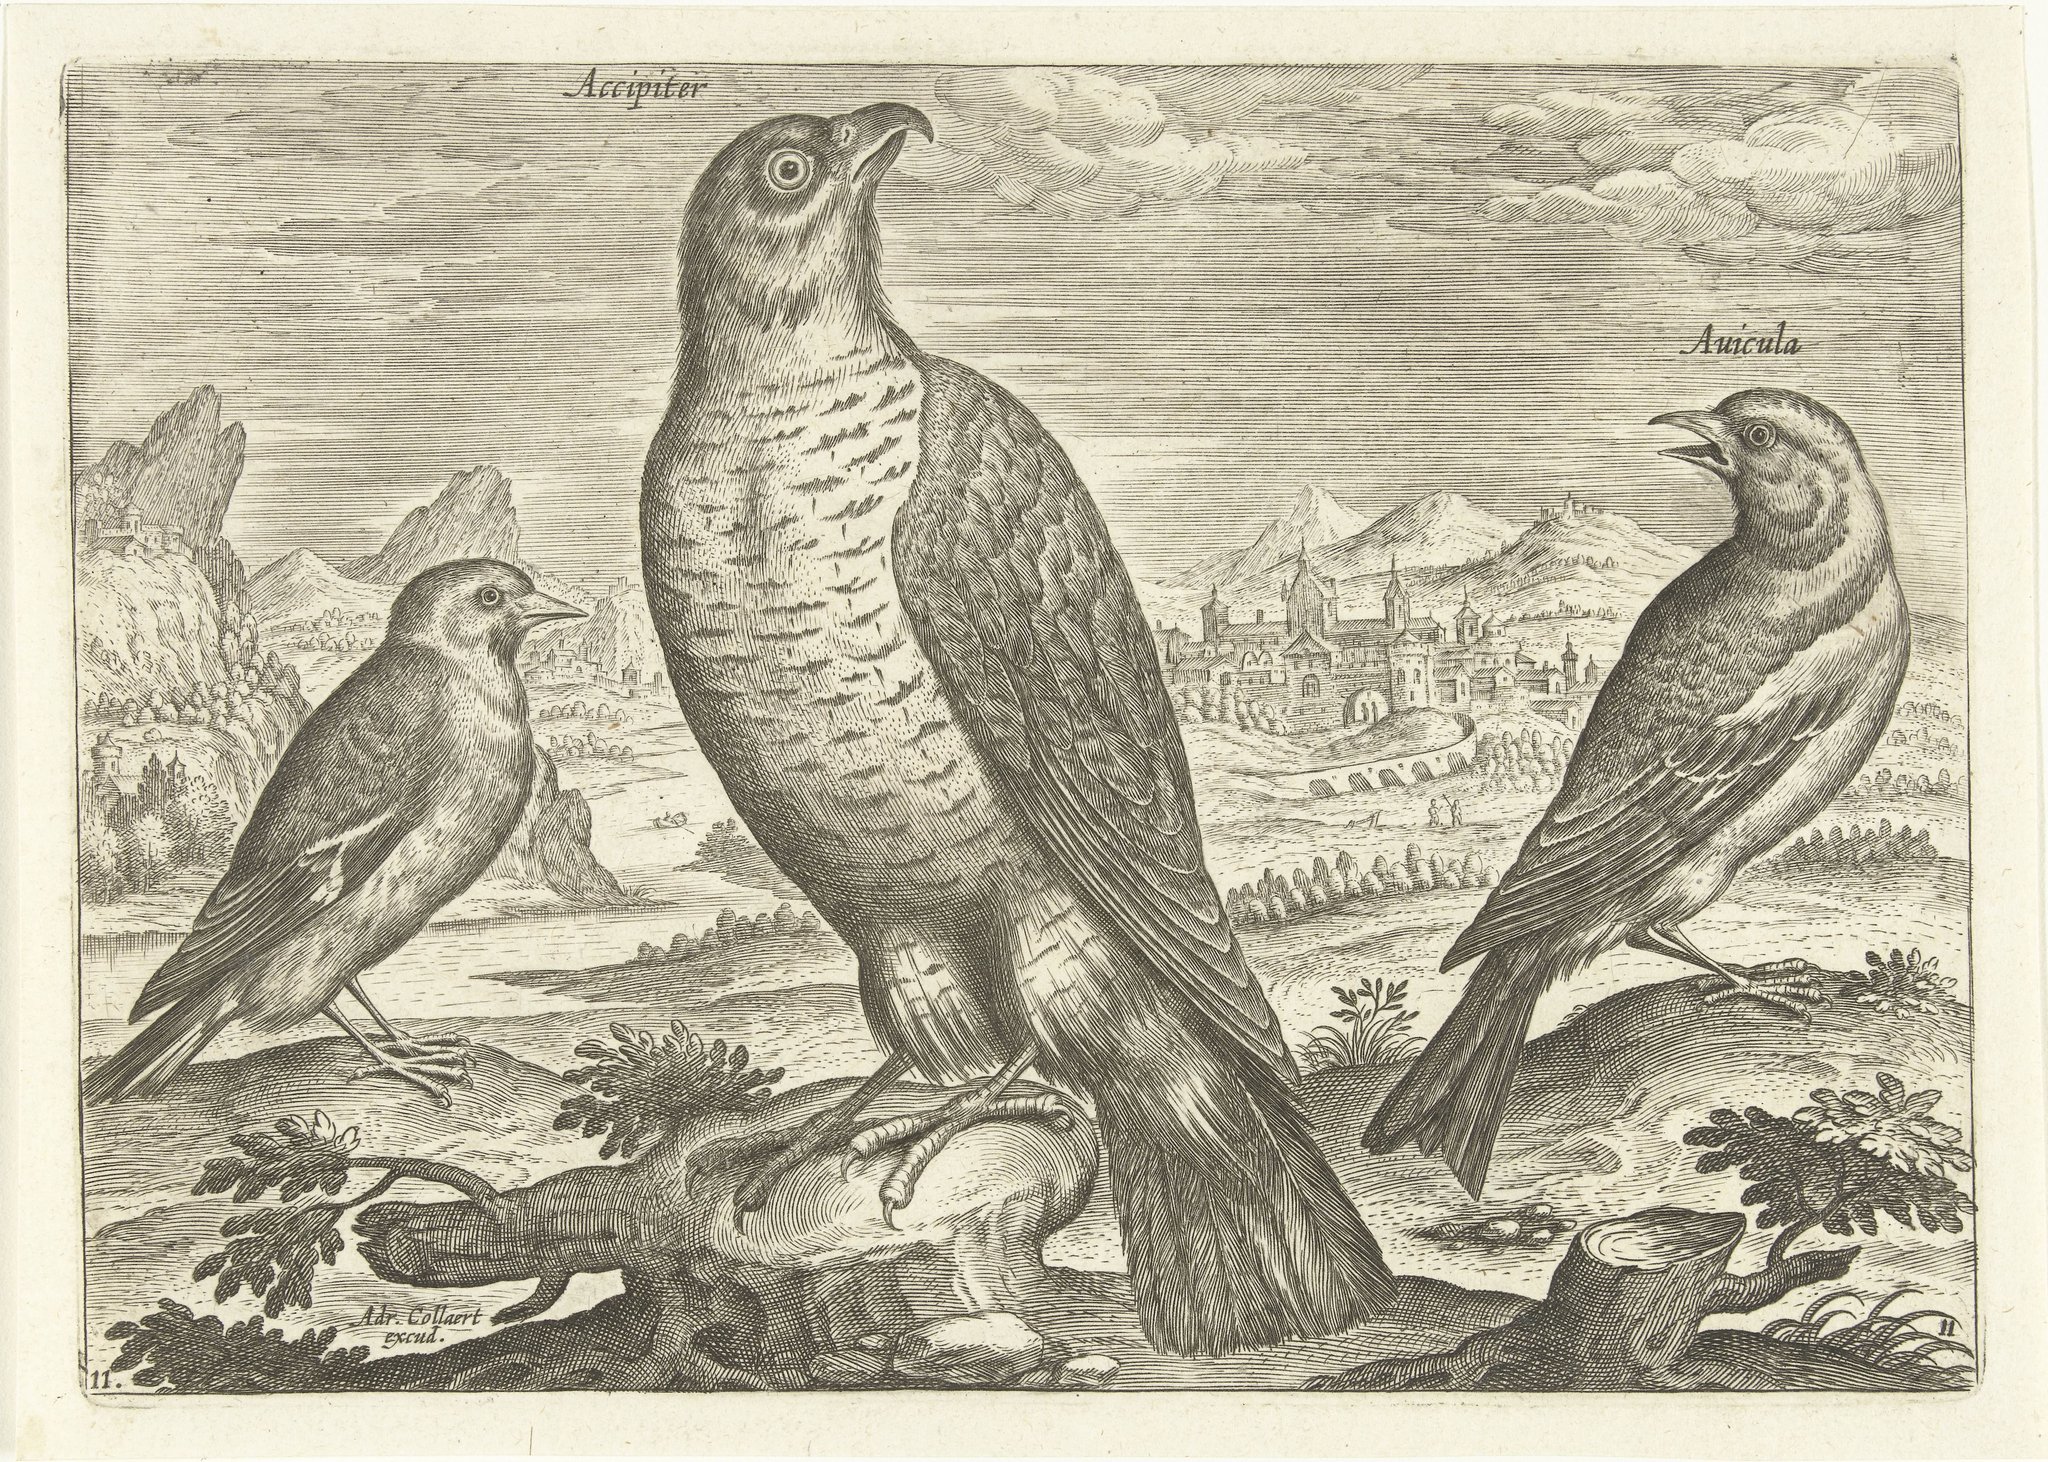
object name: print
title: Vogels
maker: adriaen collaert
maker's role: draughtsman, print maker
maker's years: 1560-1618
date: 1598-1602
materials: paper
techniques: engraving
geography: antwerp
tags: predatory birds: hawk, song-birds: sparrow, city-view in general; 'veduta' (+ city(-scape) with figures, staffage)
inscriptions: collector's mark: Lugt 2228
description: Een havik en twee mussen op de voorgrond. Op de achtergrond een landschap met een stadsgezicht. De prent maakt deel uit van een serie met vogels als onderwerp.